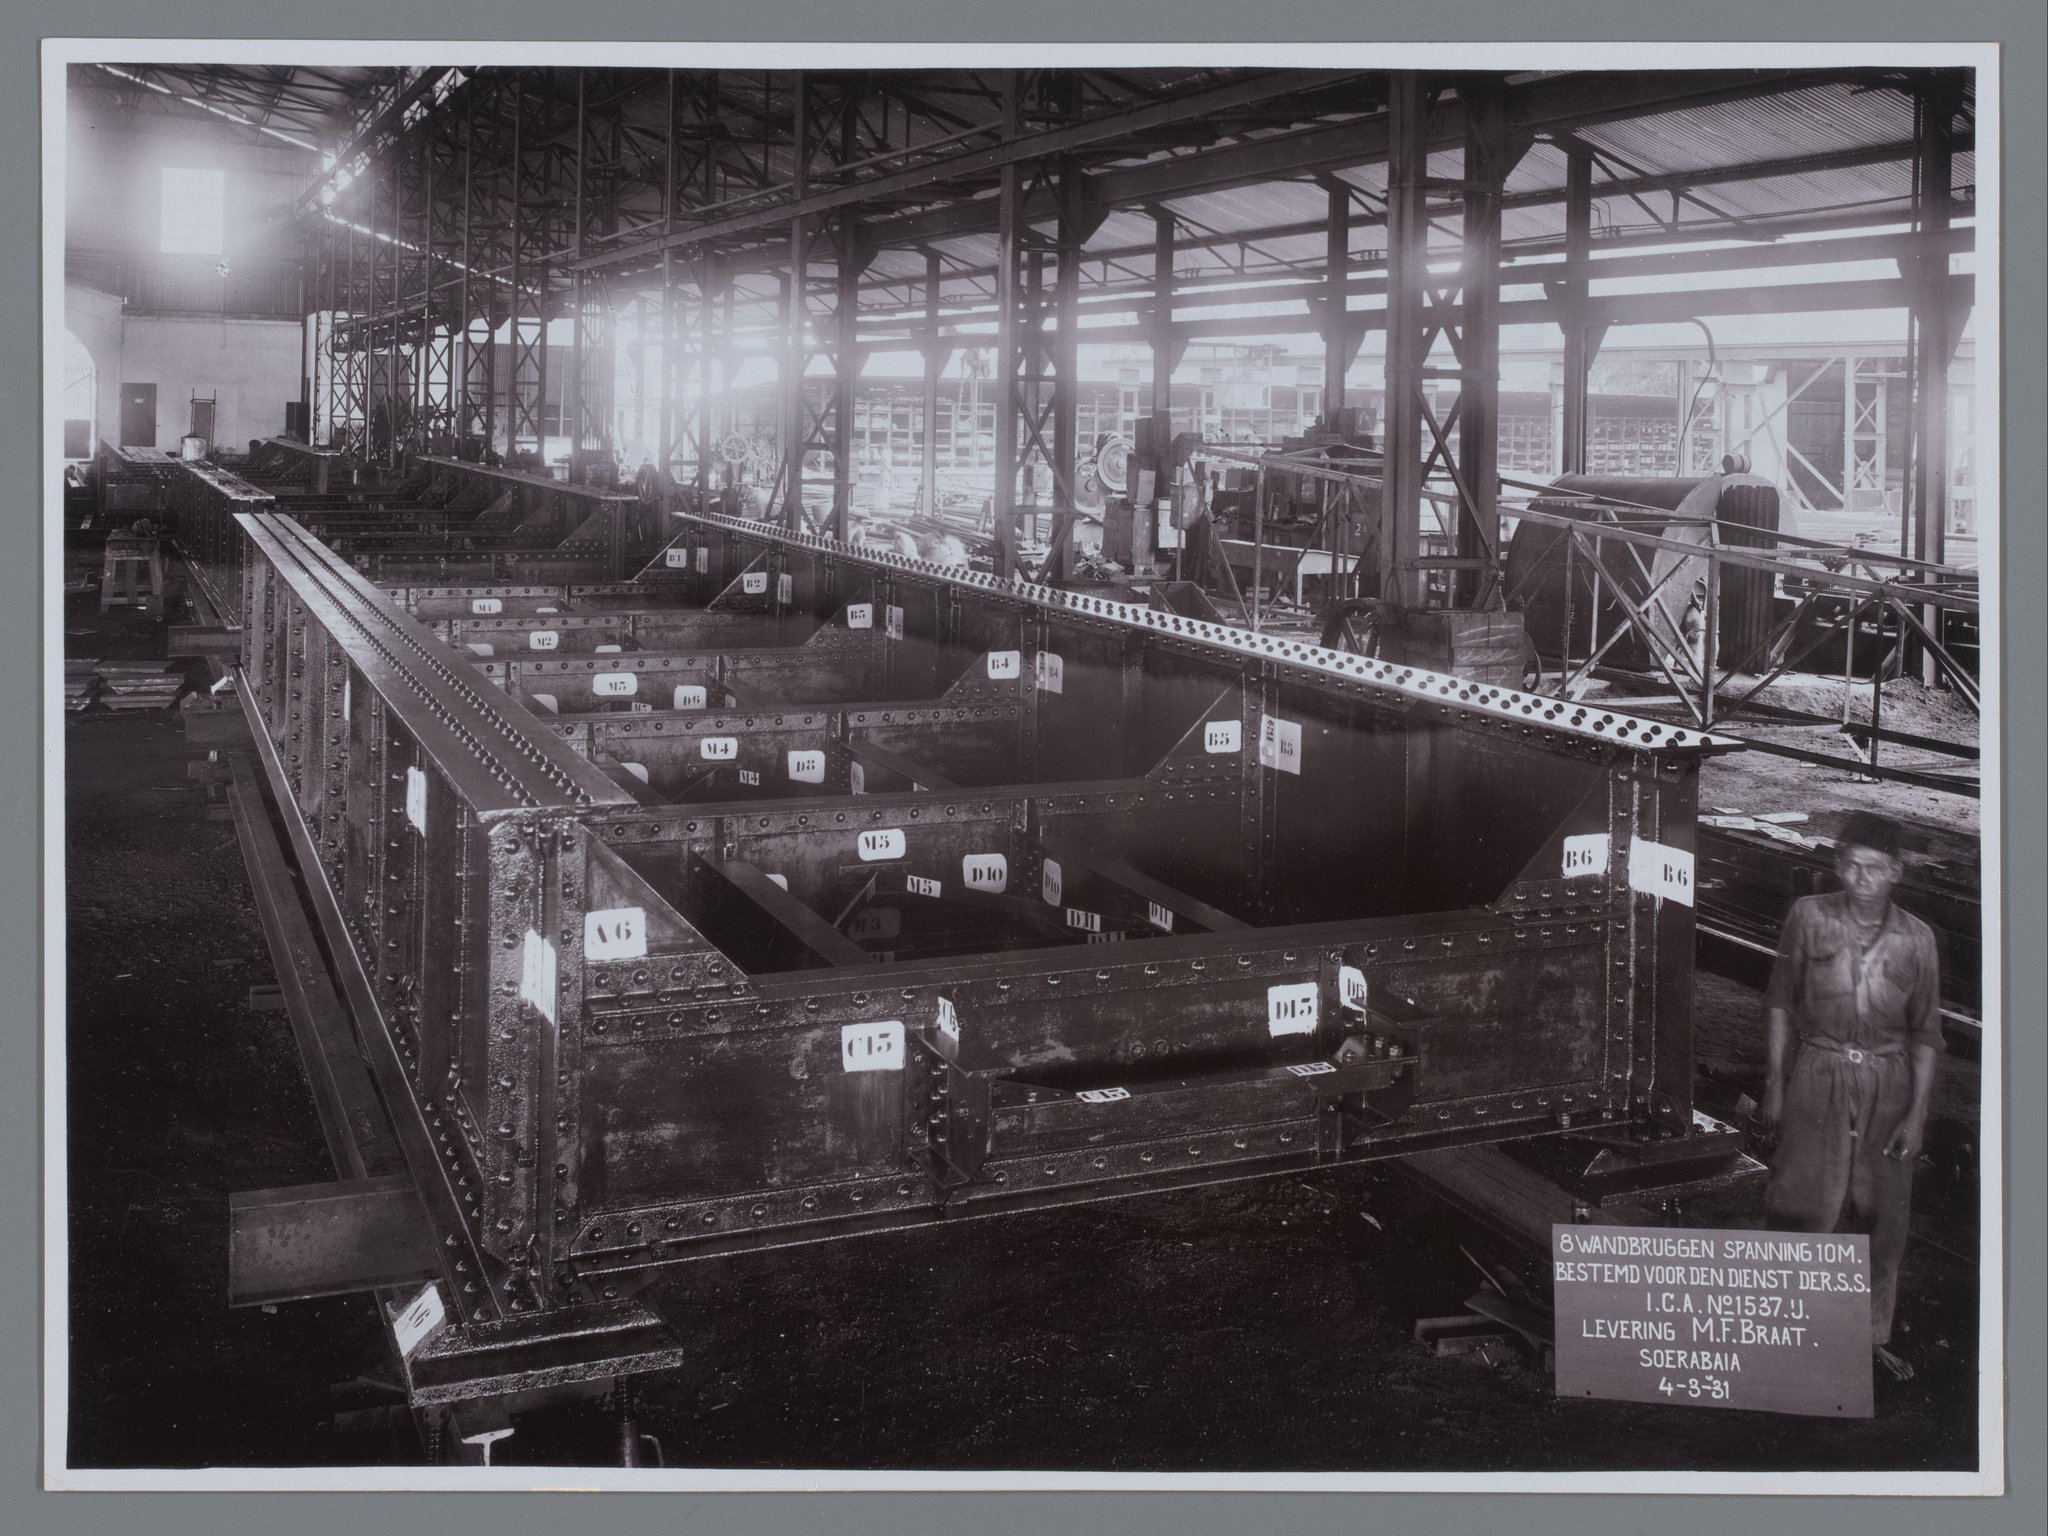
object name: photograph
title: Acht wandbruggen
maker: Anonymous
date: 1931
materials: photographic support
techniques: gelatin silver print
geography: surabaya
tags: colonial system, factory-interior, machine shop, machines; parts of machines; tools and appliances, bridge, java, dutch east indies, the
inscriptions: date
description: Acht wandbruggen vervaardigd in 1931 en bestemd voor de dienst Staatsspoorwegen van de Indische Centrale Aanschaffingsdienst (I.C.A.). Onderdeel van de multomap met foto's van bruggen gebouwd door de N.V. Machinefabriek Braat te Soerabaja en bestemd voor verschillende plaatsen in Nederlands-Indië, uit de periode 1931-1940.